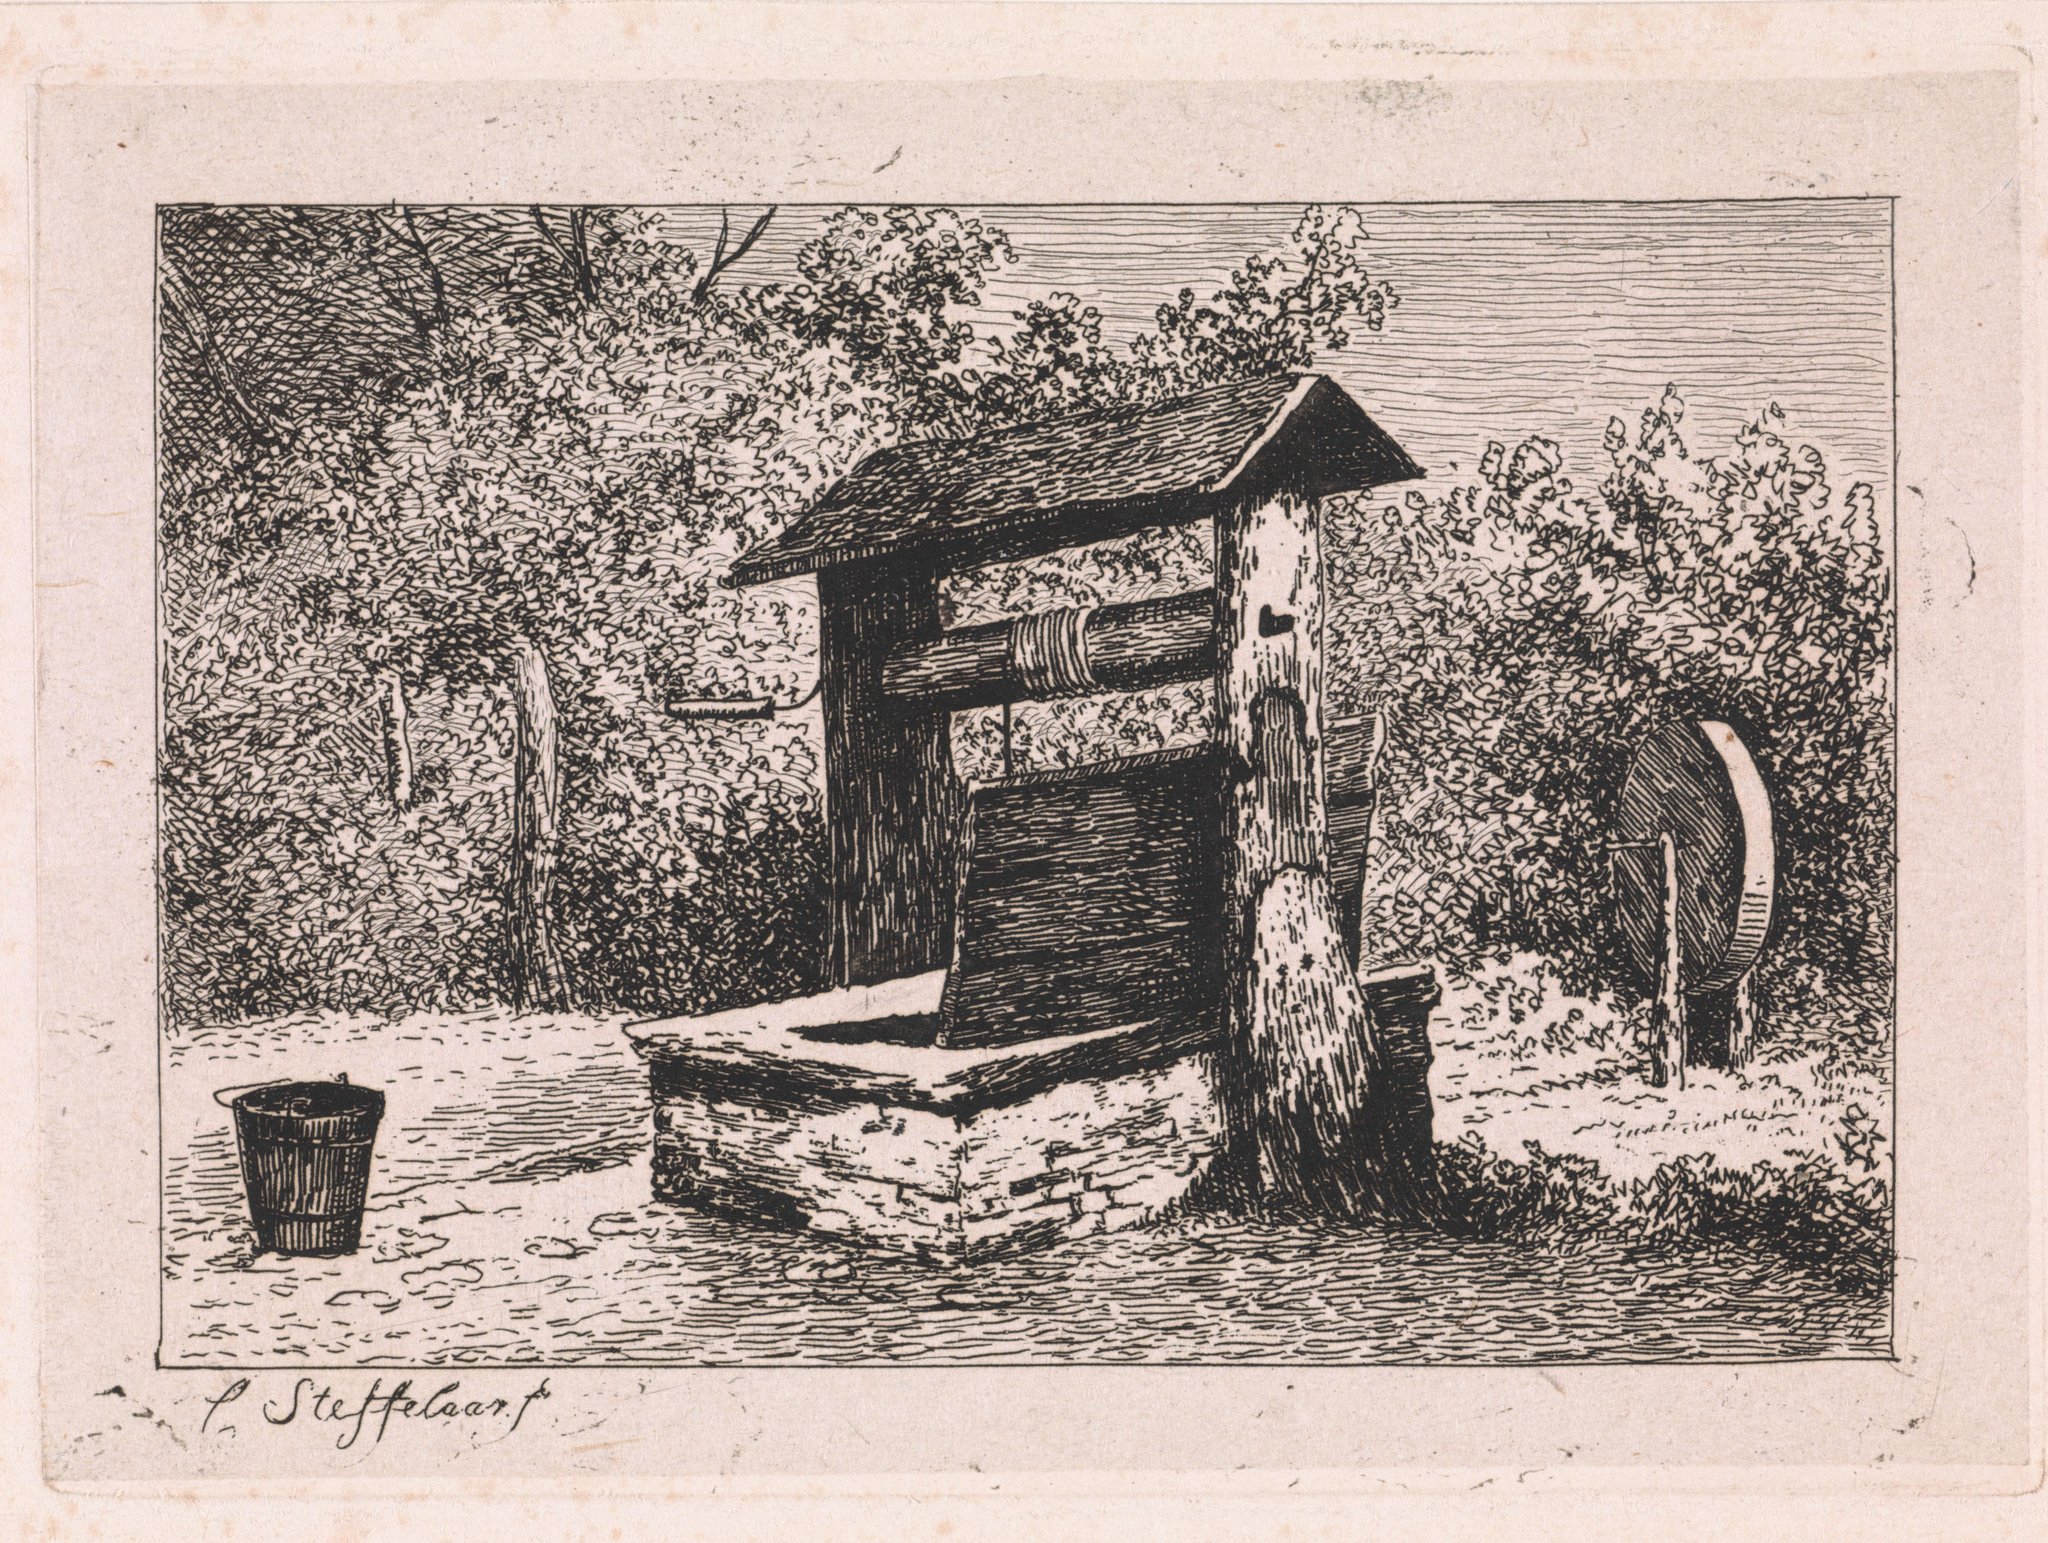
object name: print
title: Vijfde suite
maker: cornelis steffelaar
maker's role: draughtsman, painter, print maker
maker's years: 1797-1861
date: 1807-1861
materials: paper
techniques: etching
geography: amsterdam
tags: well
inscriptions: collector's mark: Lugt 2228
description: Een waterput met windas en afdak. Links een emmer.